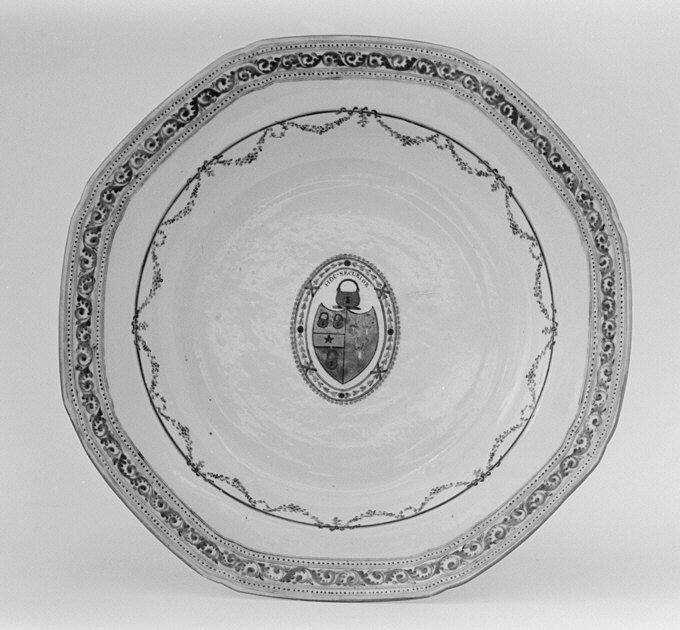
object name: soup plate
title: Soup plate (part of a service)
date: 1770-1785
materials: hard paste porcelain